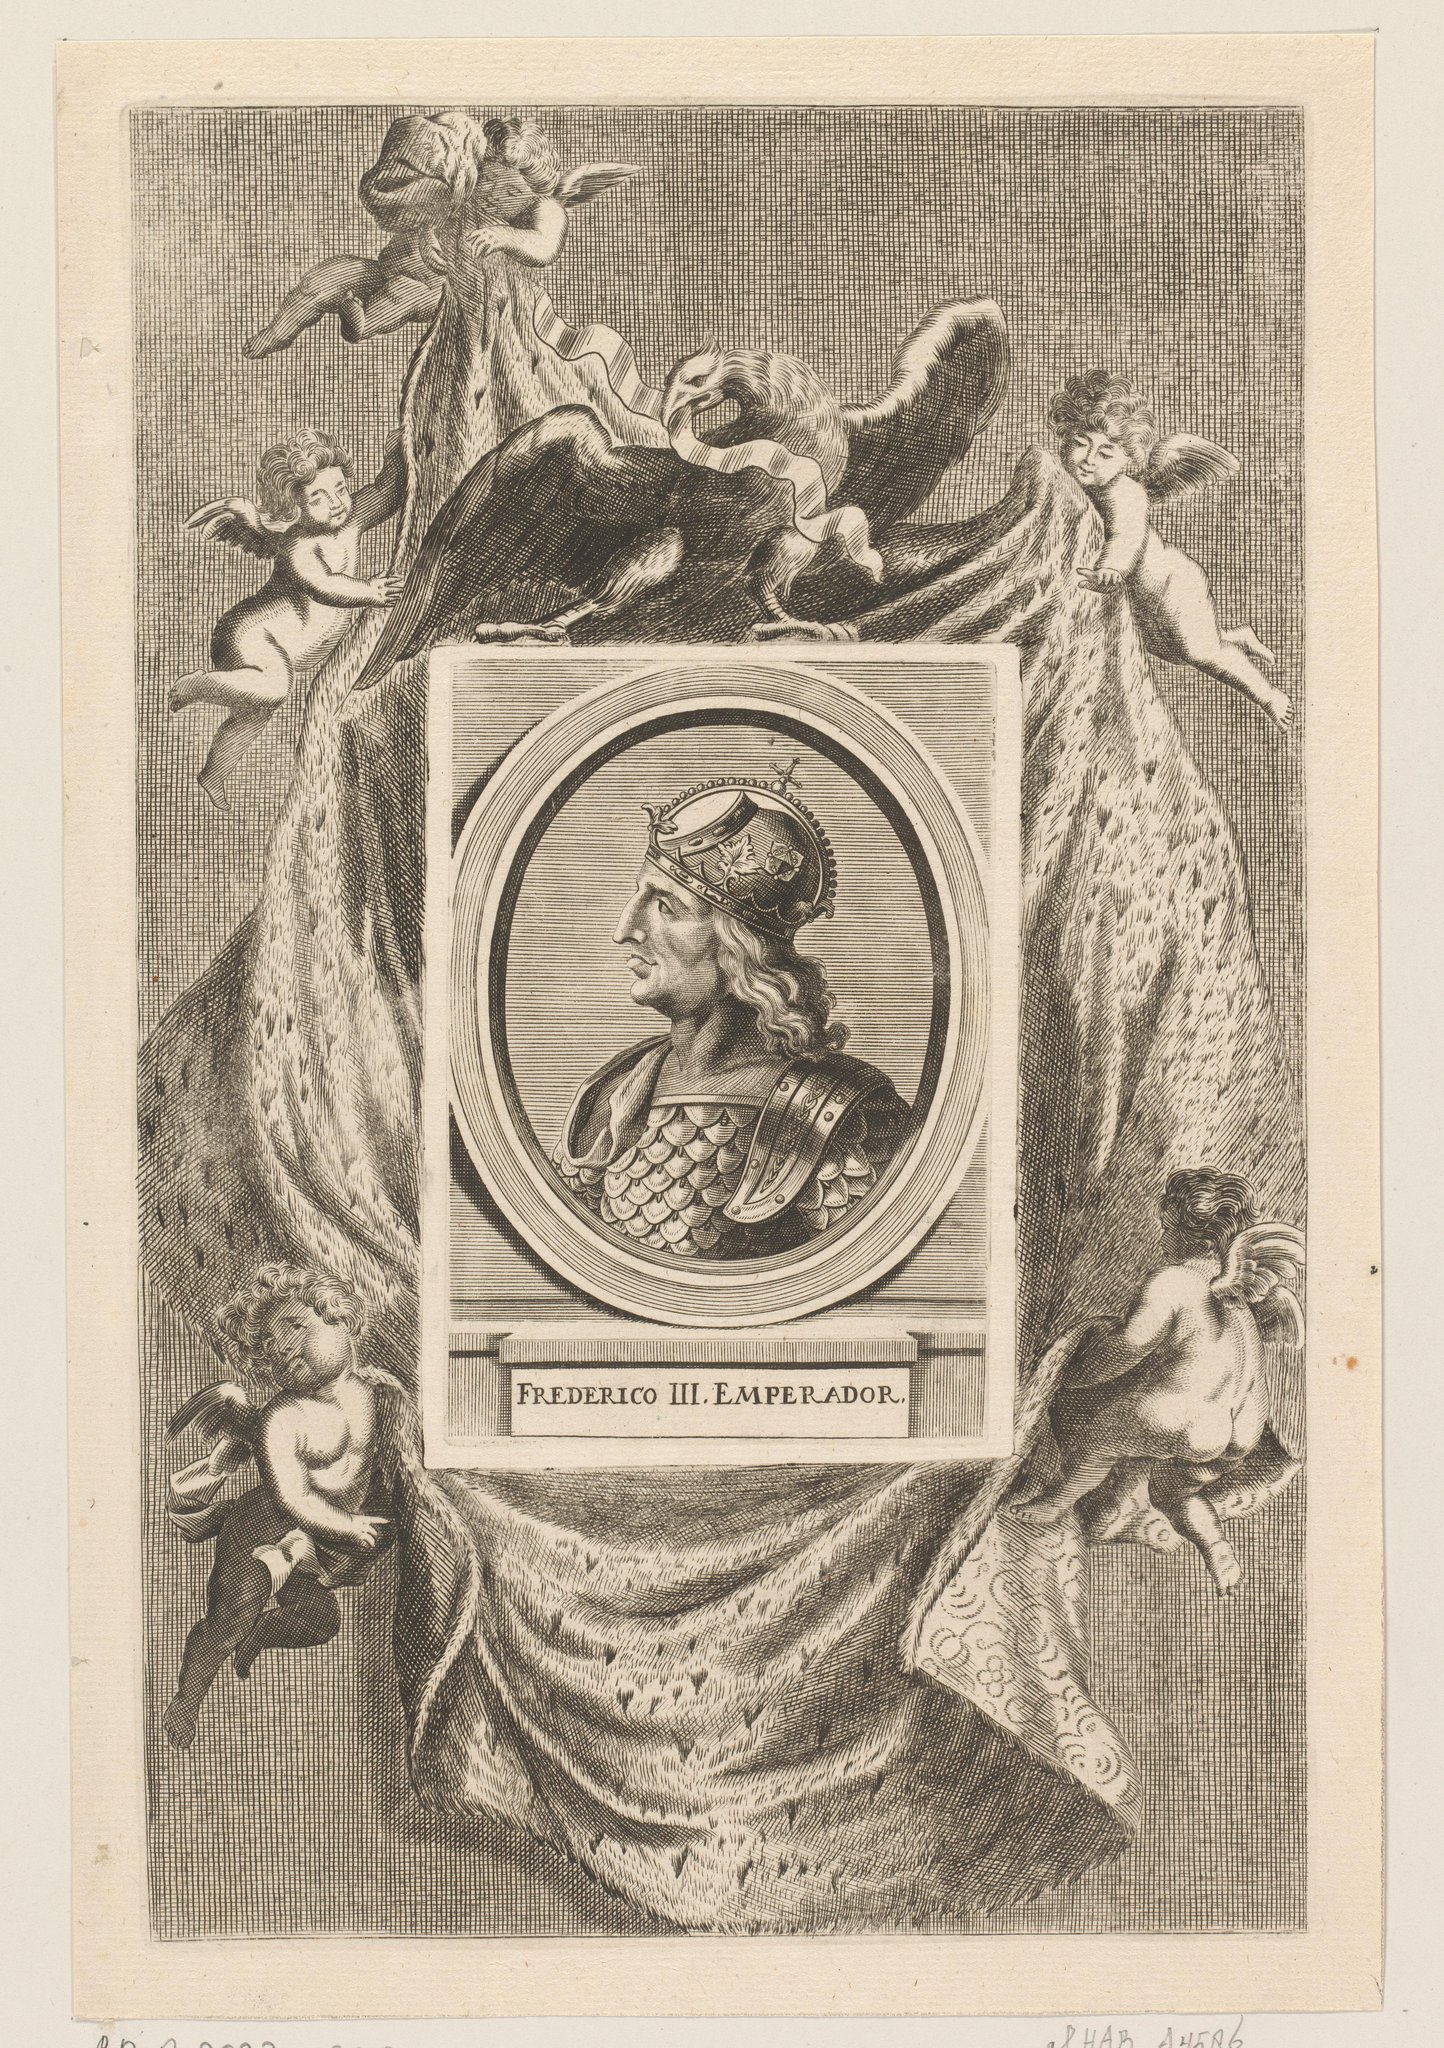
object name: book illustration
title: Portret van keizer Frederik III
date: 1713-1714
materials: paper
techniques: engraving, etching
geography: low countries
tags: historical persons, emperor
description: Prent waarschijnlijk uit: Komen, Filips van. Las Memorias (...). Antwerpen: Hendrik en Cornelis Verdussen, 1713, dl. 1. Of uit de editie uit 1714.